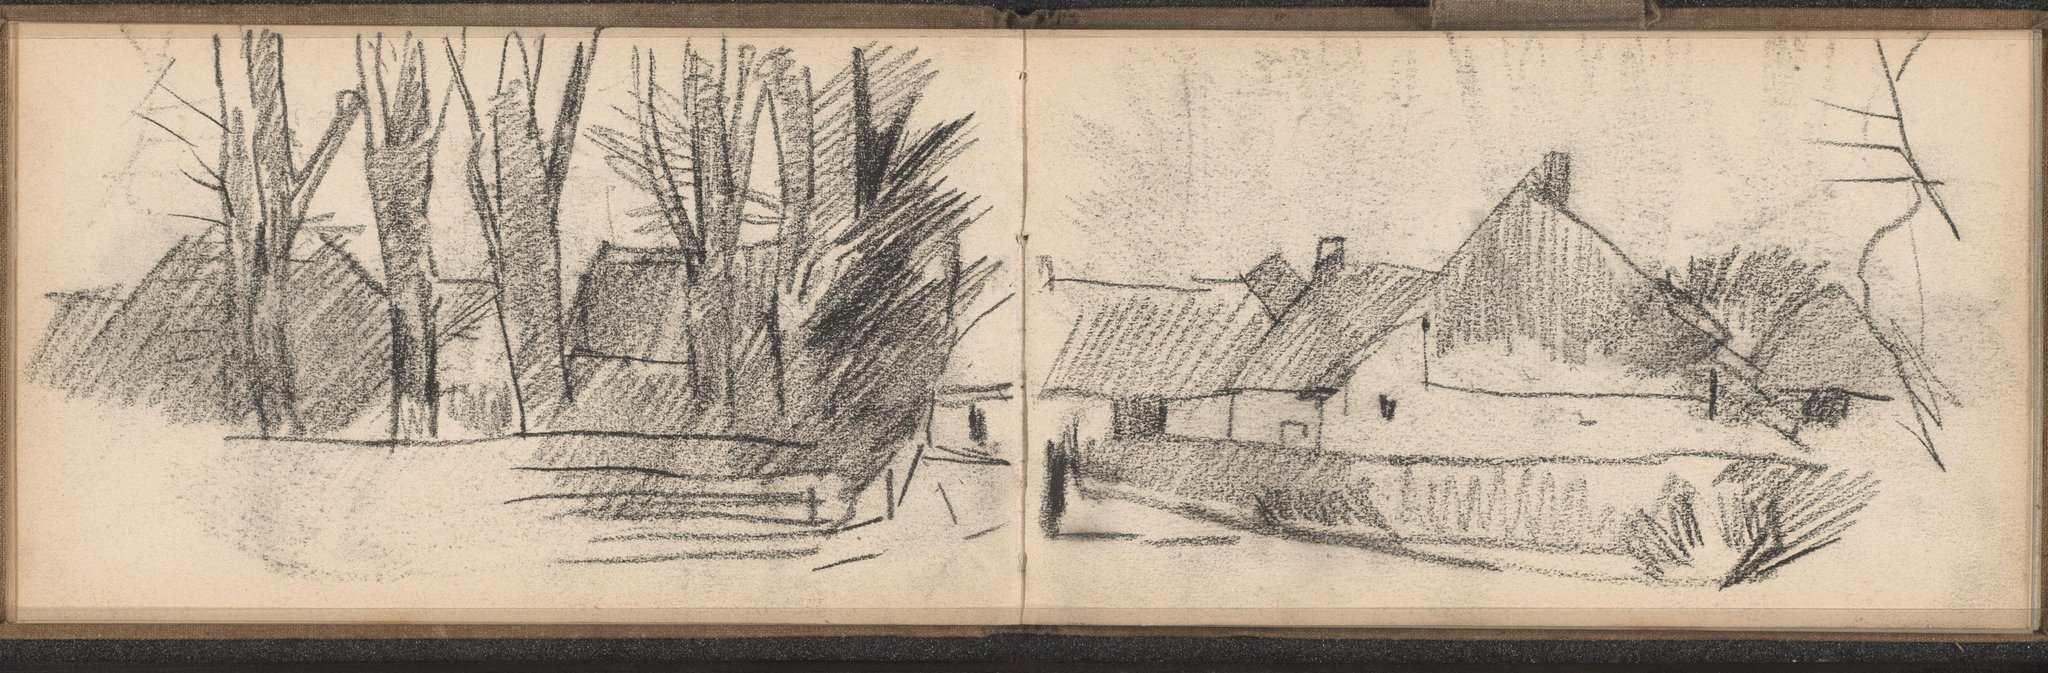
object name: sketchbook leaf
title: Landschap met boerderijen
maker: george hendrik breitner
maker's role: draughtsman, painter, print maker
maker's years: 1857-1923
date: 1883-1885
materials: chalk, paper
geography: drenthe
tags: farm or solitary house in landscape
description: Pagina 29 en pagina 30 uit een schetsboek met 48 bladen.